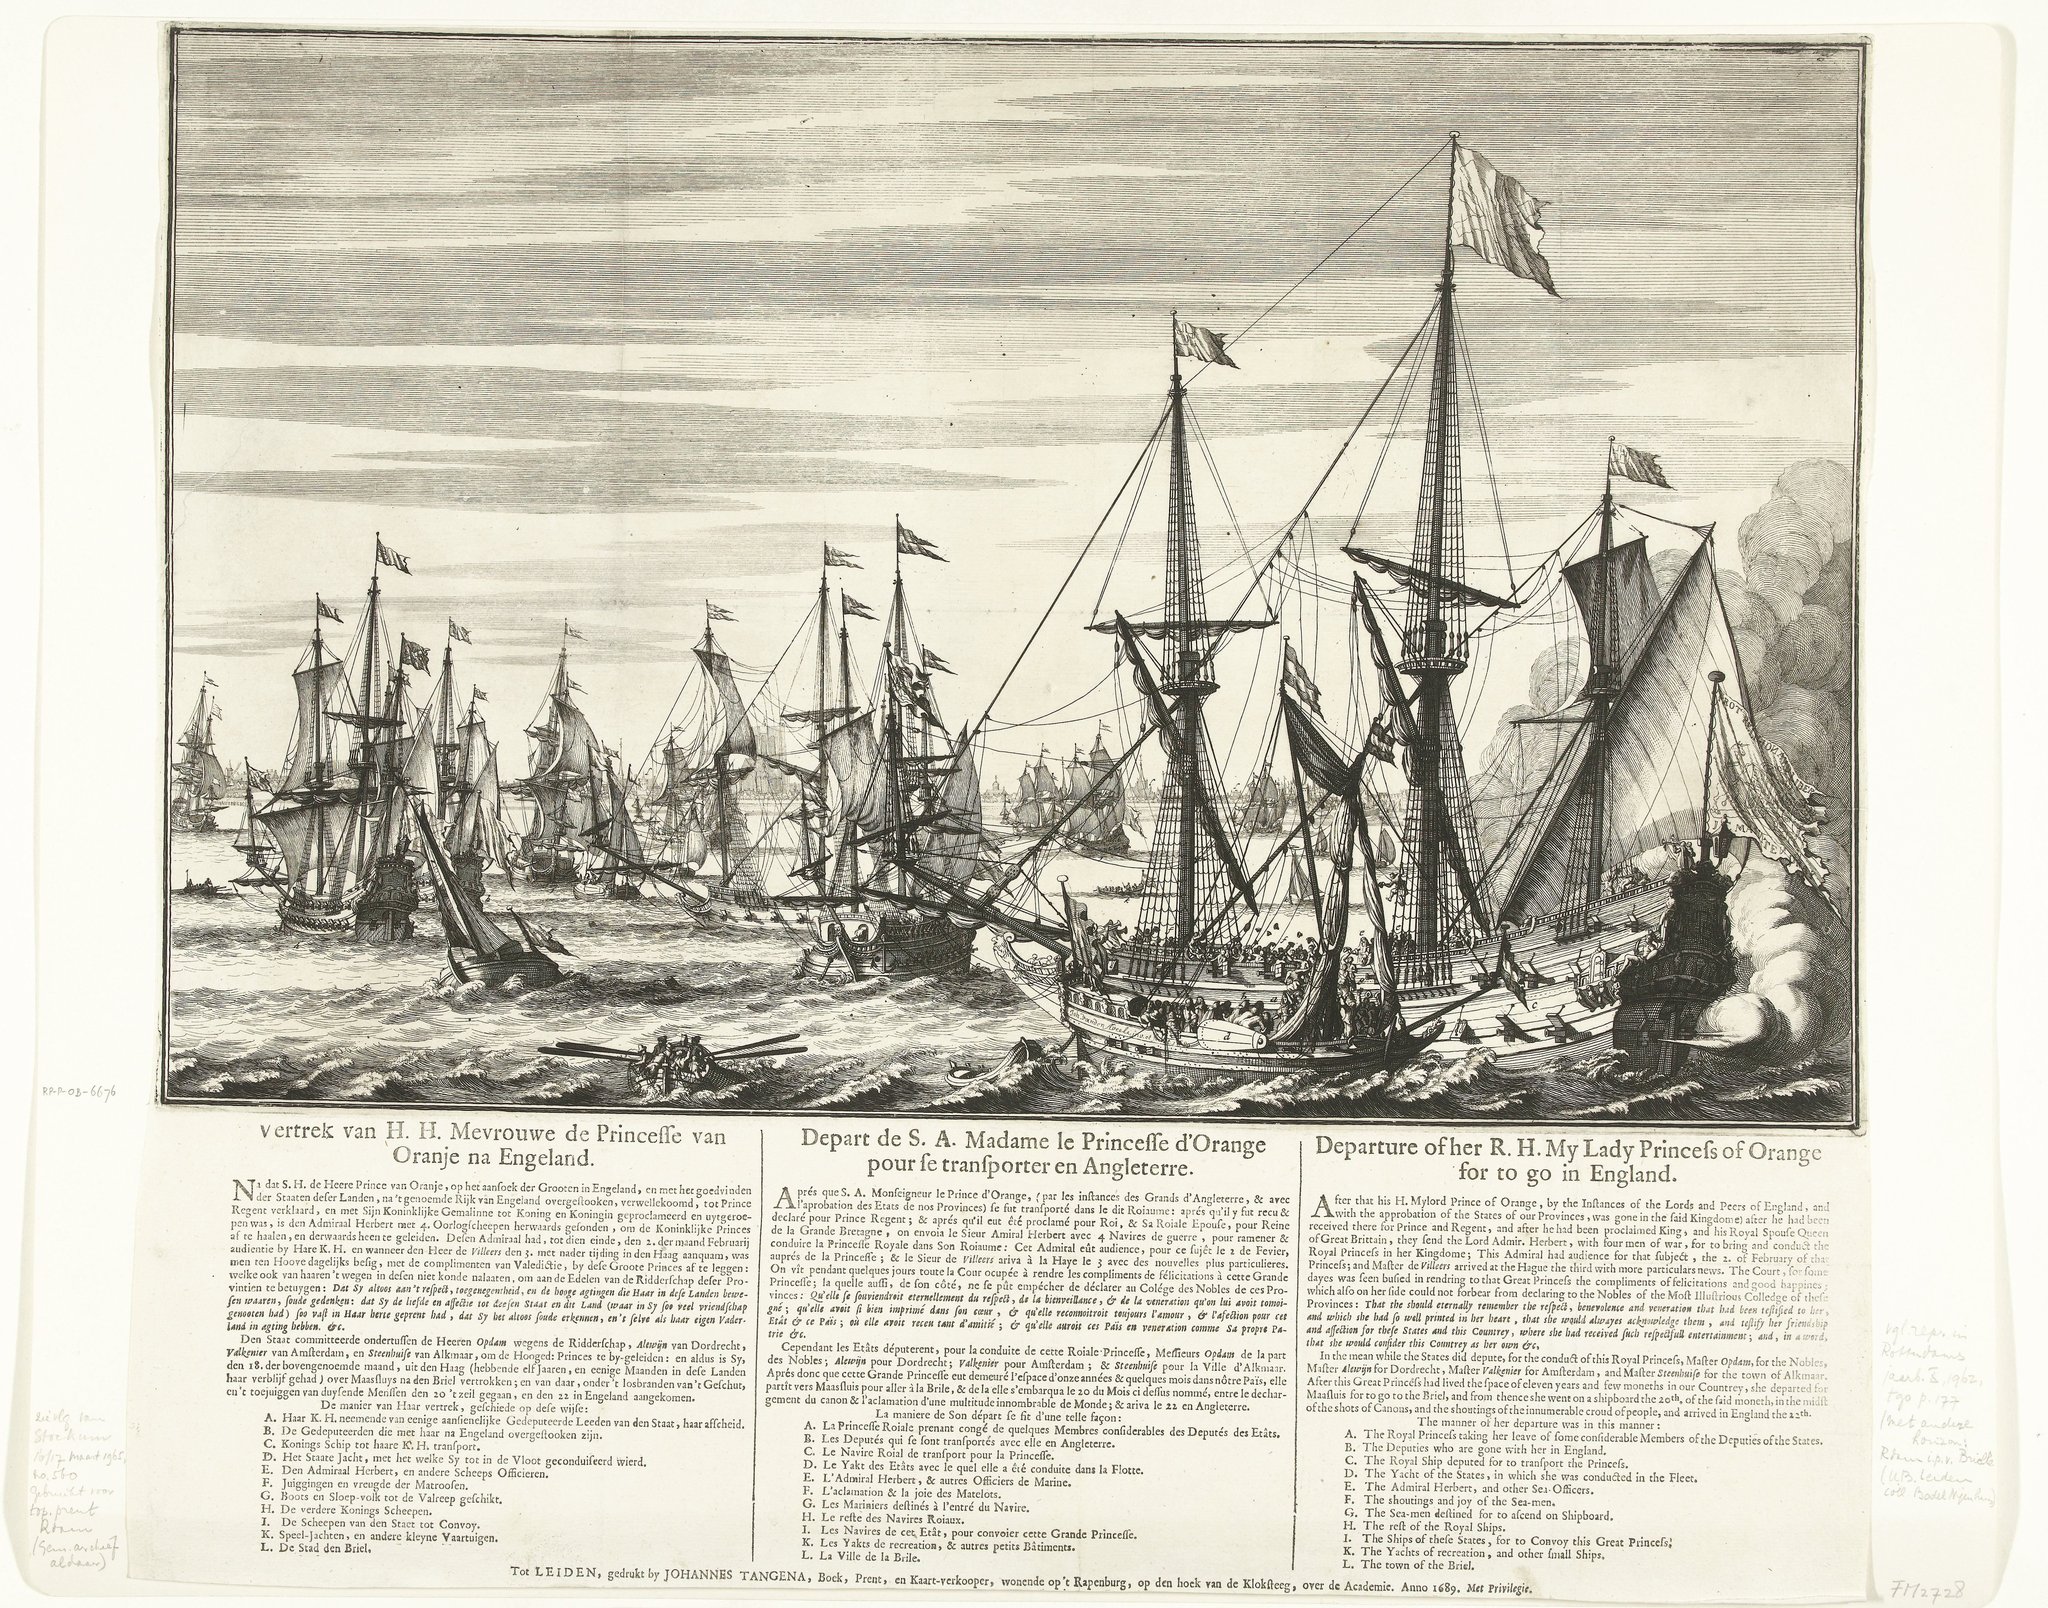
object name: print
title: Vertrek van de prinses van Oranje naar Engeland, 1689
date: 1689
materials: paper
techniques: etching, letterpress printing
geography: northern netherlands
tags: london, maria ii stuart (koningin van engeland, schotland en ierland), arrival and return ~ travelling, brielle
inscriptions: date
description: Vertrek van prinses Maria Stuart uit Brielle op 20 februari 1689 om zich te voegen bij haar echtgenoot in Londen. De prinses stapt over van het Statenjacht naar het schip dat haar naar Engeland zal brengen. Onder de plaat drie teksten met de legenda's A-L in het Nederlands, Frans en Engels.